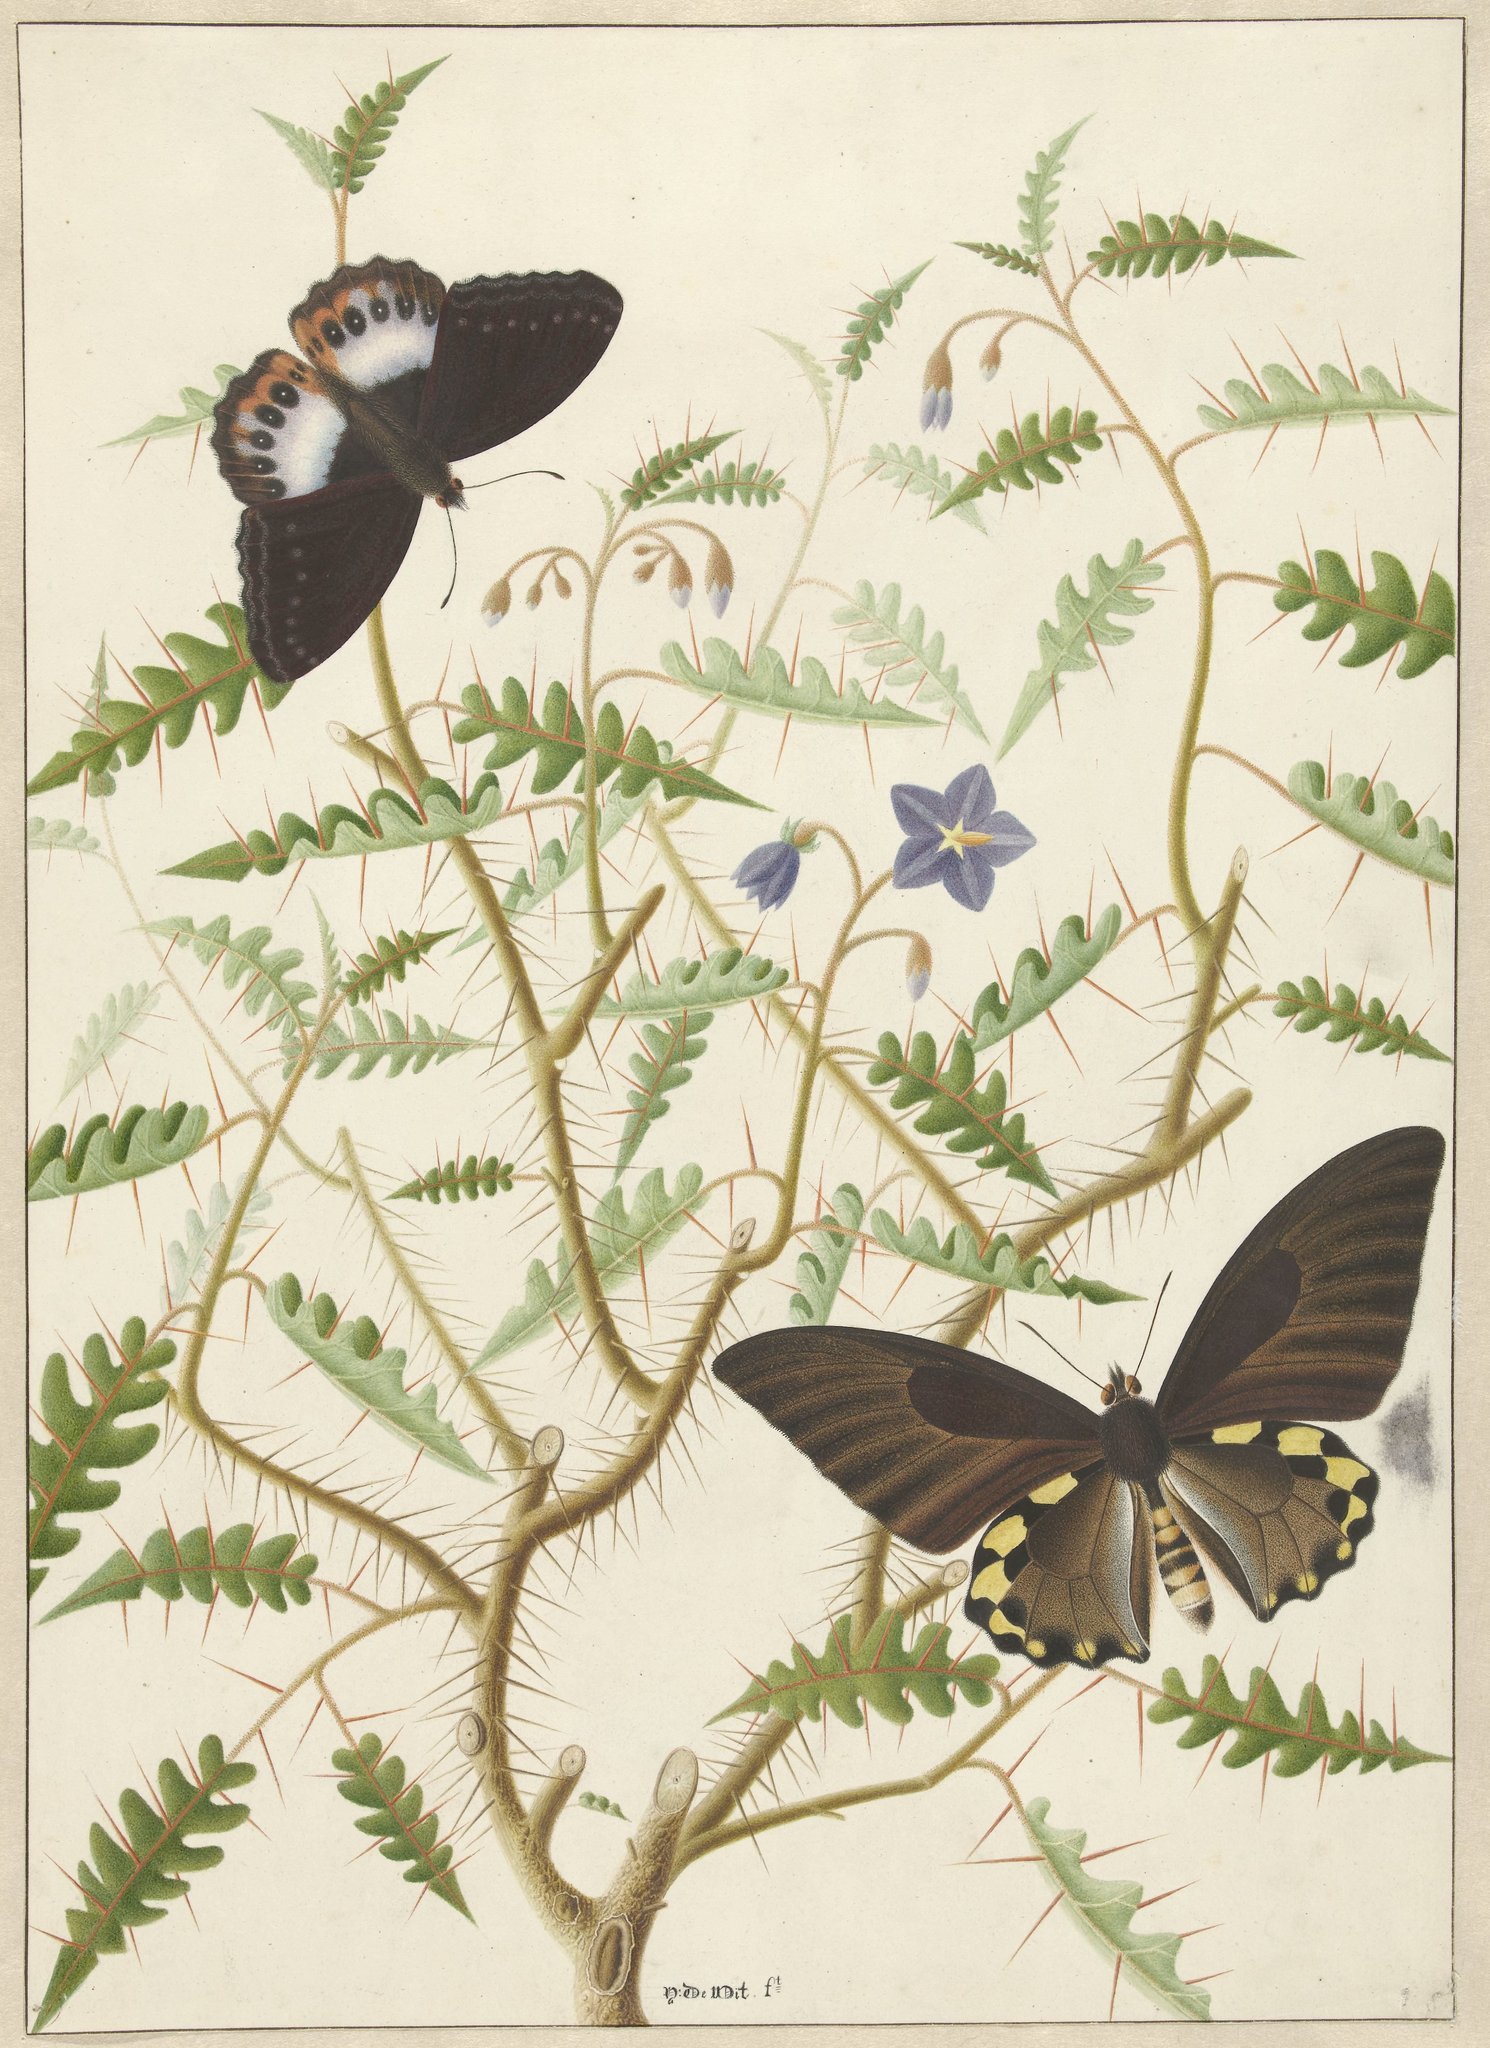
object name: drawing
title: Two Exotic Butterflies on a Blooming Bush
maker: hermanus de wit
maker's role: draughtsman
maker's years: 1764-1842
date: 1774-1842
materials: paper, watercolor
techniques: brush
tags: trees, insects: butterfly